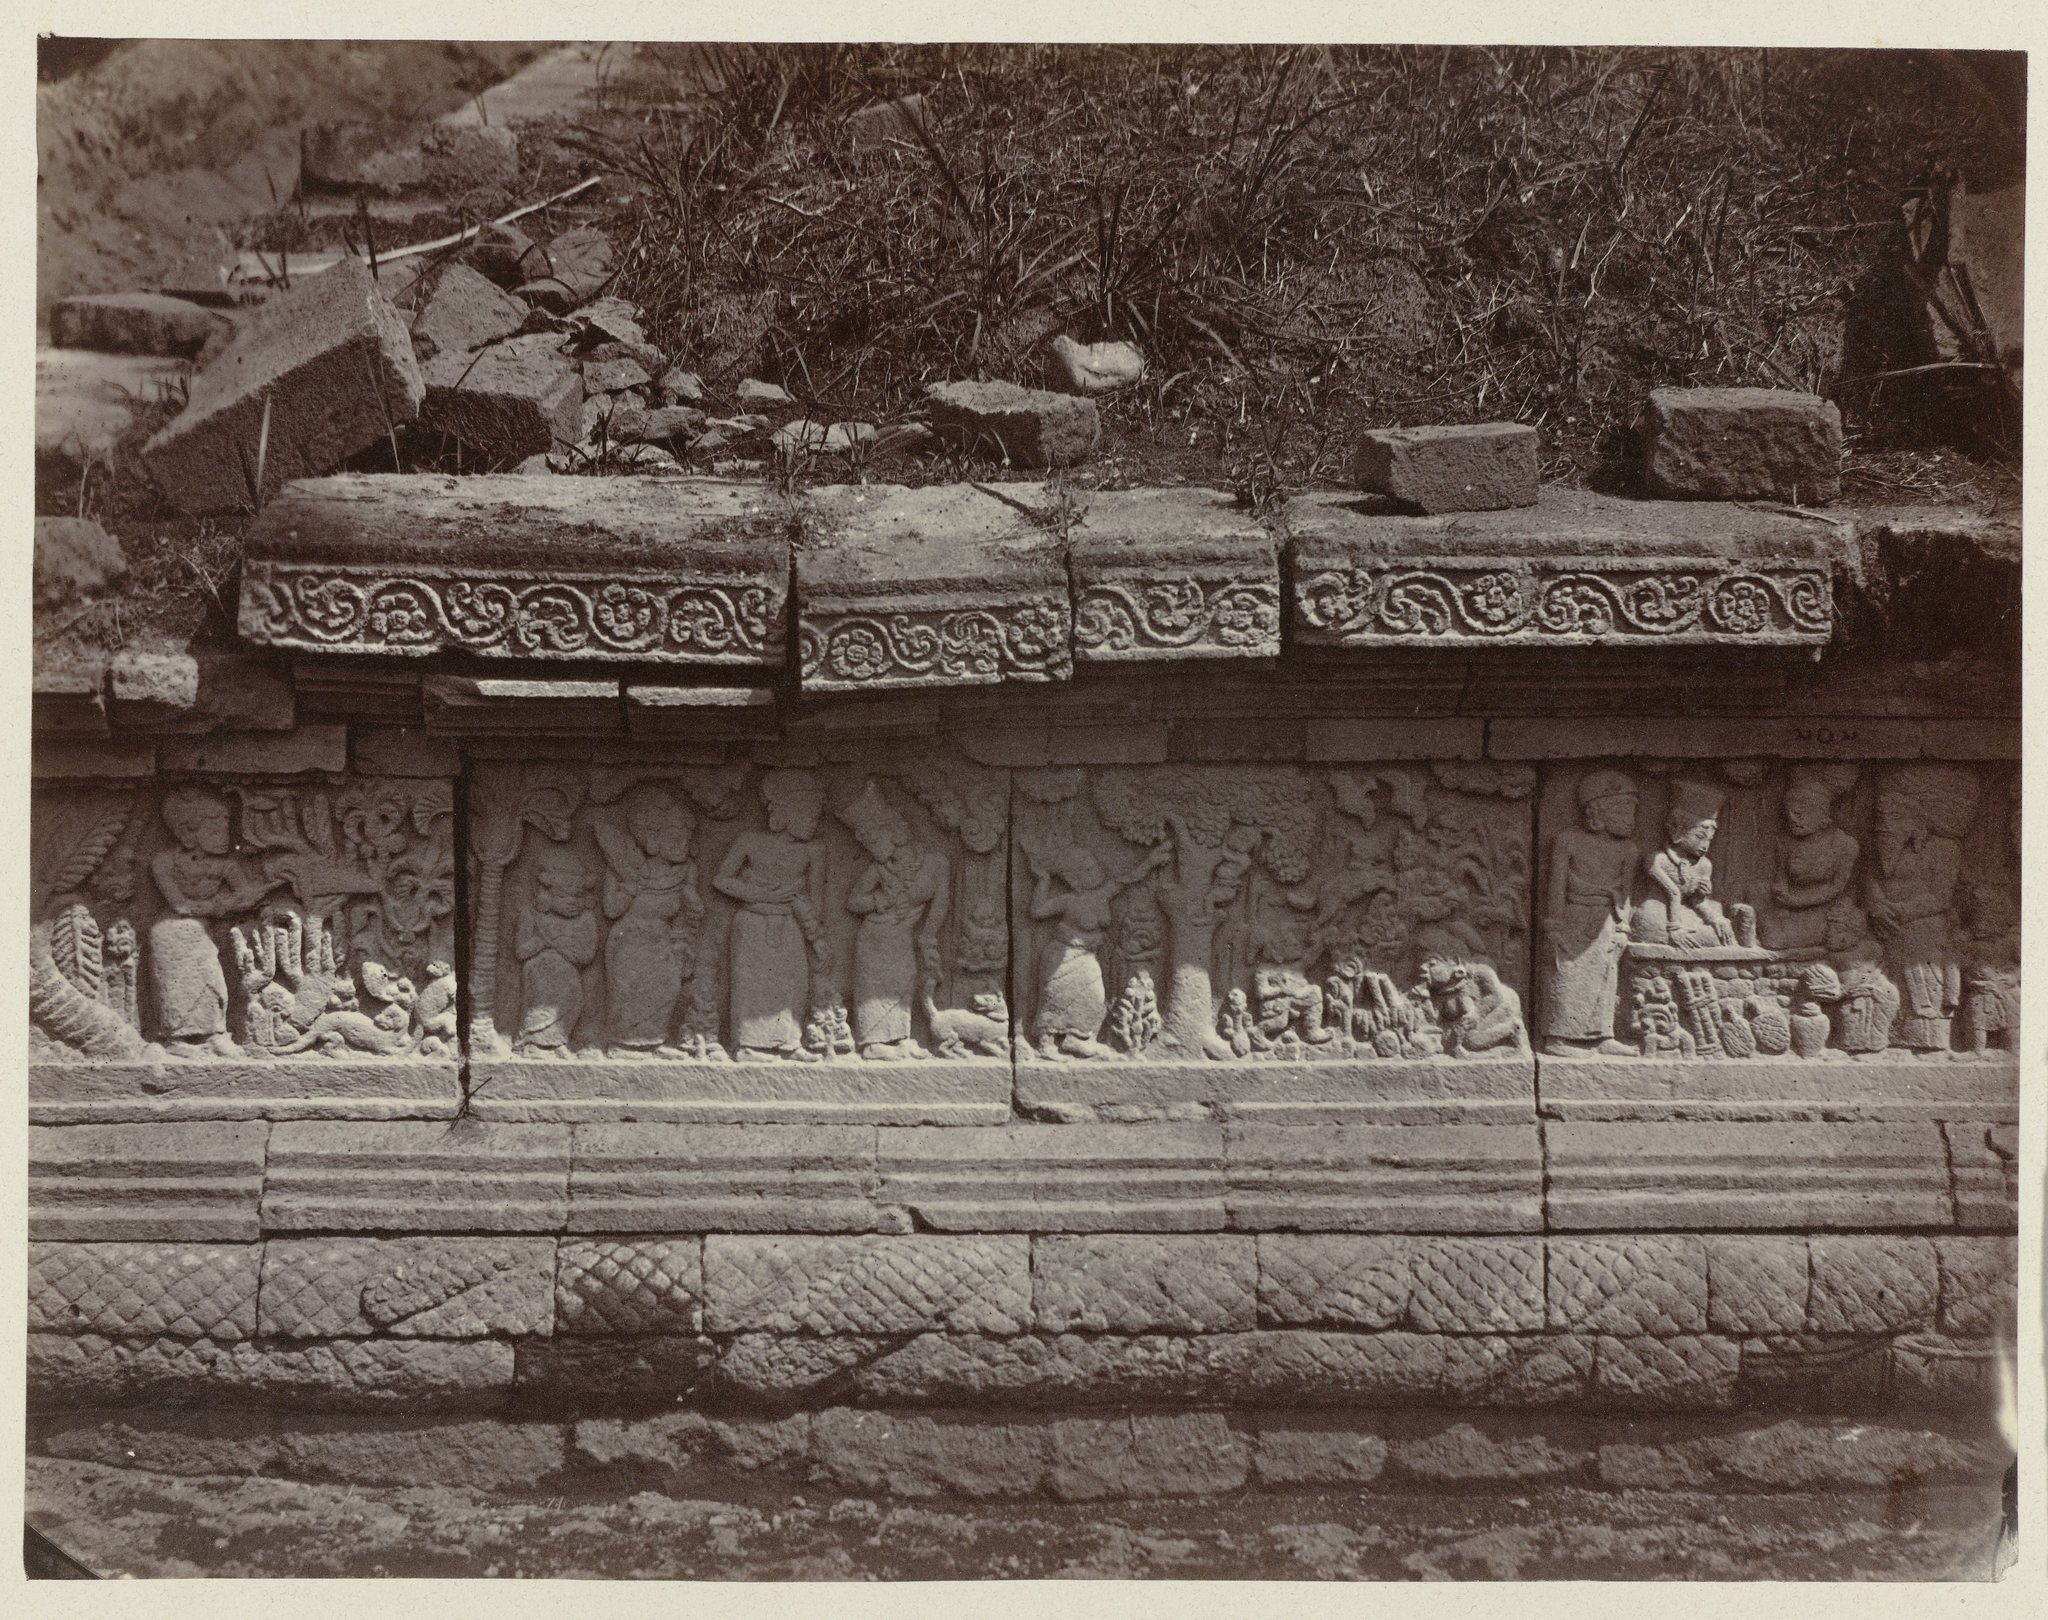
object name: photograph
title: Basreliëf op het pendopo voetstuk aan de noordzijde van Candi Panataran.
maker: isidore kinsbergen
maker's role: fotograaf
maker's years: 1821-1905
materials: cardboard, paper, photographic support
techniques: albumen print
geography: java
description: Candi Panataran (Temple Complex), Pendopo Terrace, unidentified reliefs 40-43 (inscription above no. 43 reads samasa), north side. Panataran, Blitar district, East Java province, 1375 AD